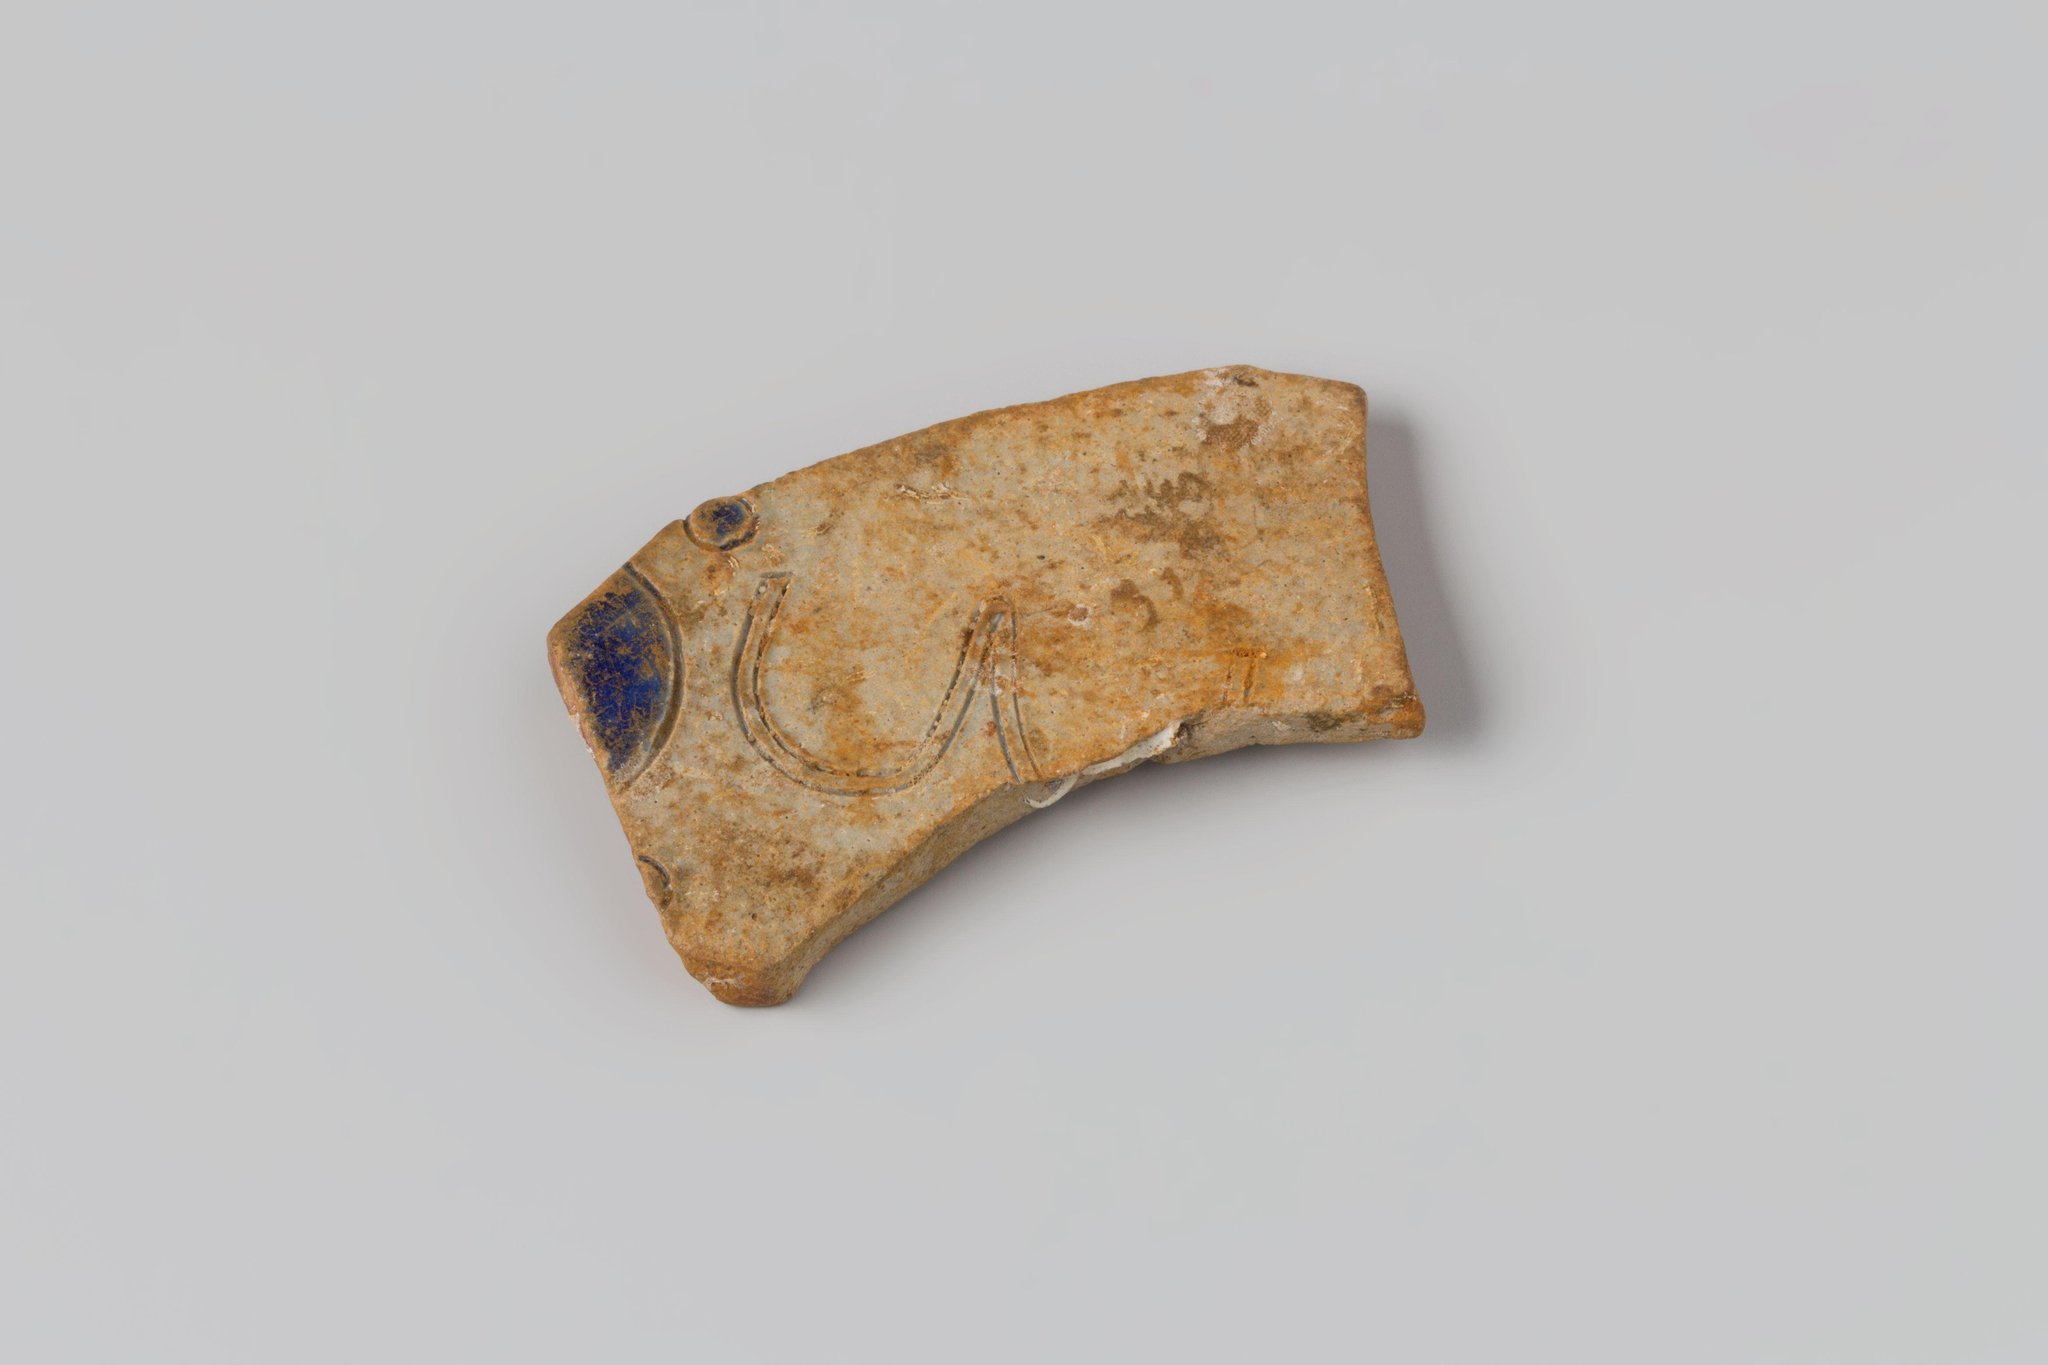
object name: sherd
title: Scherf van een pot uit het wrak van de Oost-Indiëvaarder Hollandia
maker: Anonymous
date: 1700-1743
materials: earthenware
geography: westerwald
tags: verenigde oostindische compagnie, hollandia (schip), annet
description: Stoneware, Rhenish, Westerwald, pot; of body, sim. NG 1980-27H2624r.